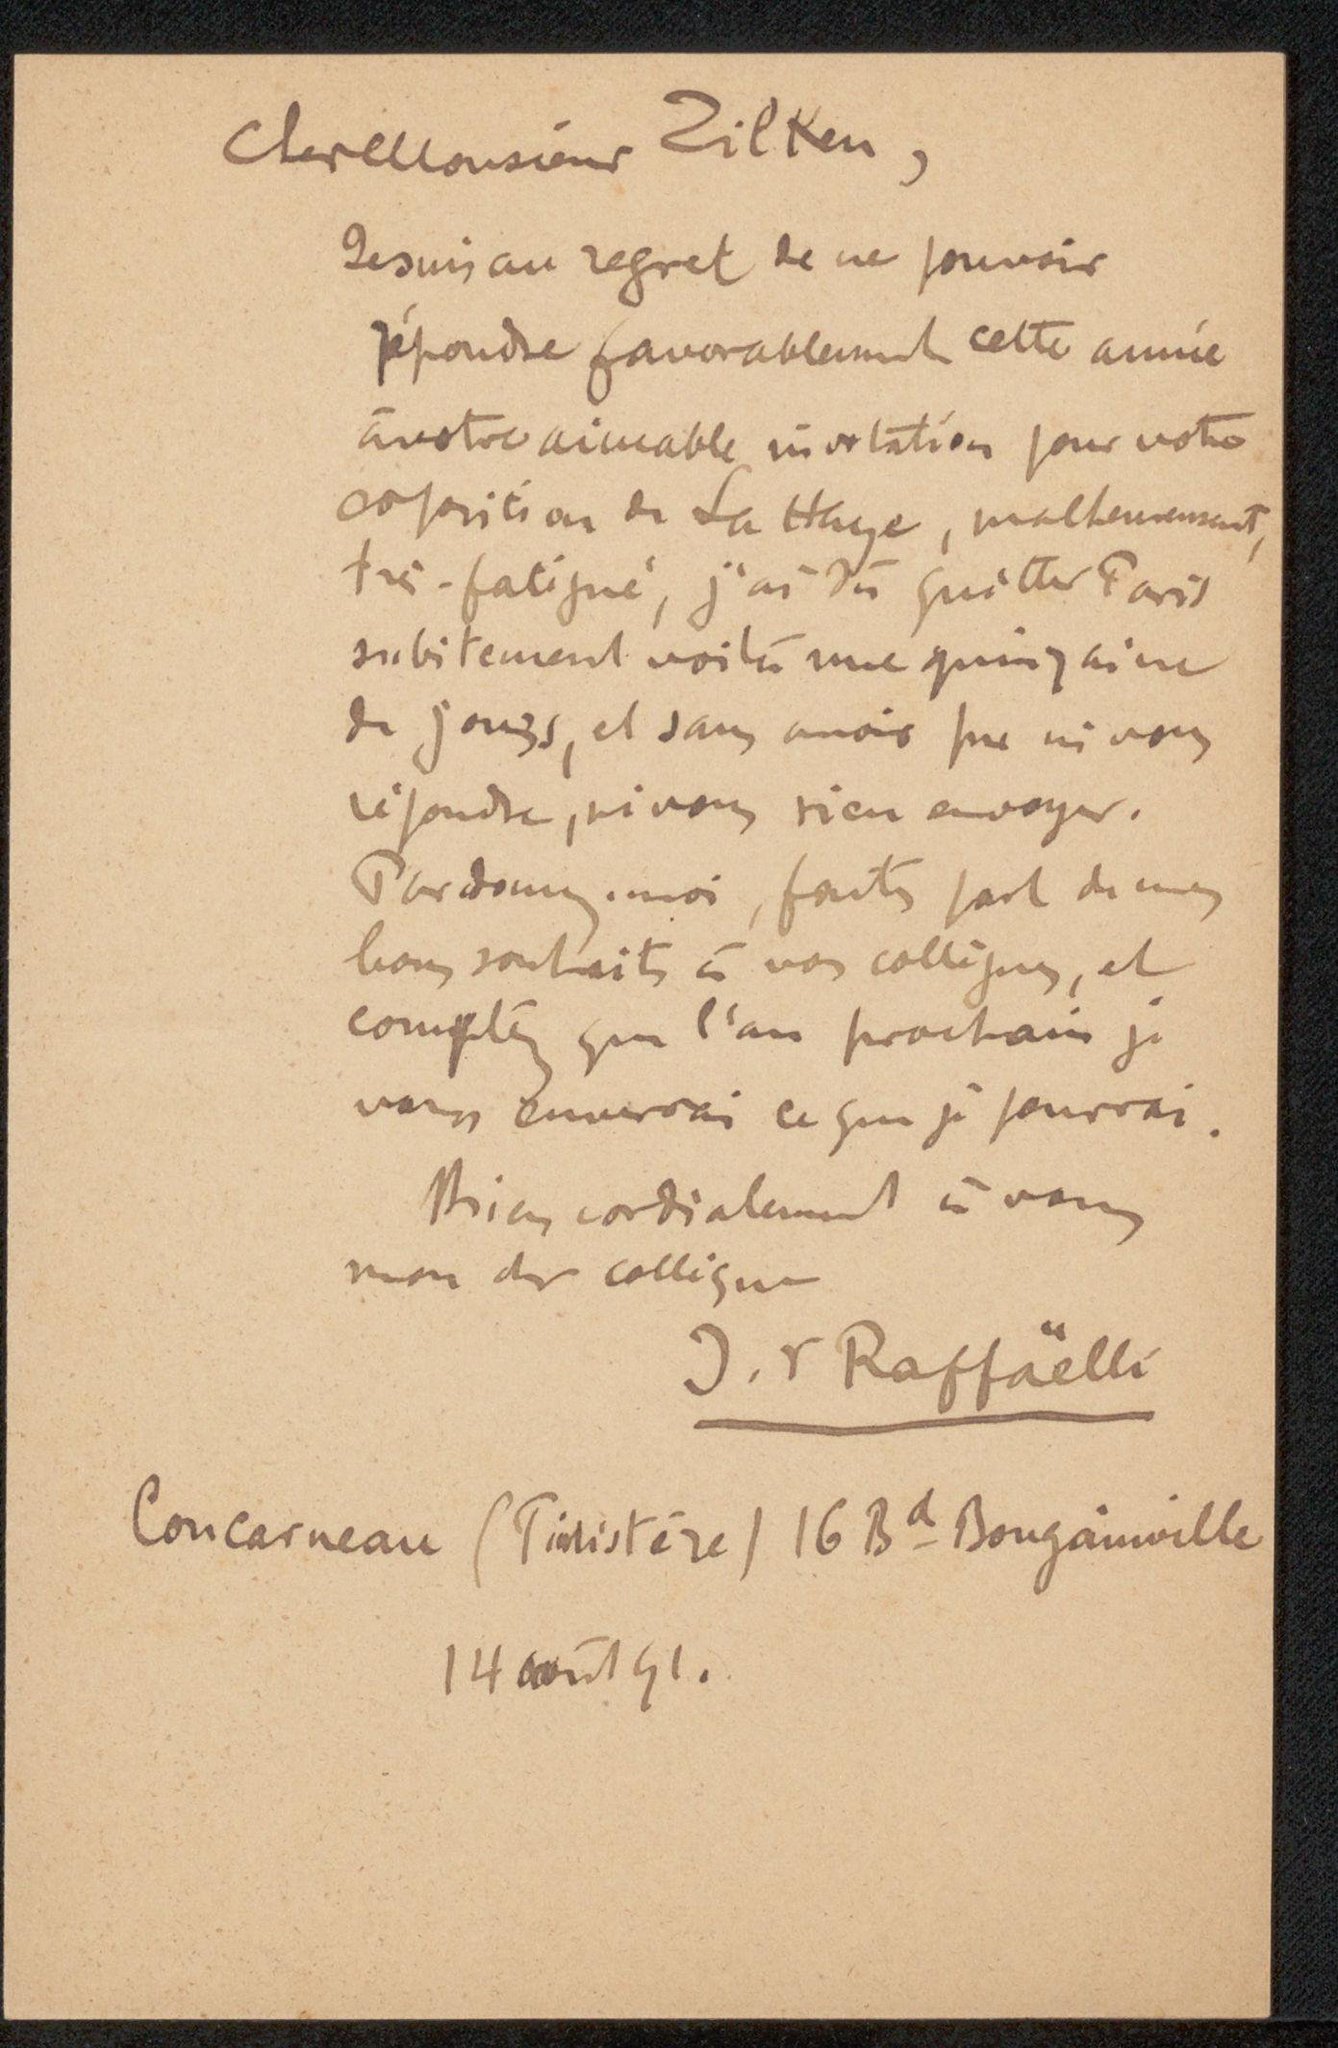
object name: letter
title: Brief aan Philip Zilcken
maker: jean françois raffaëlli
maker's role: print maker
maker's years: 1850-1924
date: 1891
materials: ink, paper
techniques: pen, writing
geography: concarneau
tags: painter, draughtsman, philip zilcken, exhibition ~ art, the hague, paris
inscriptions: collector's mark: ‘RPK’